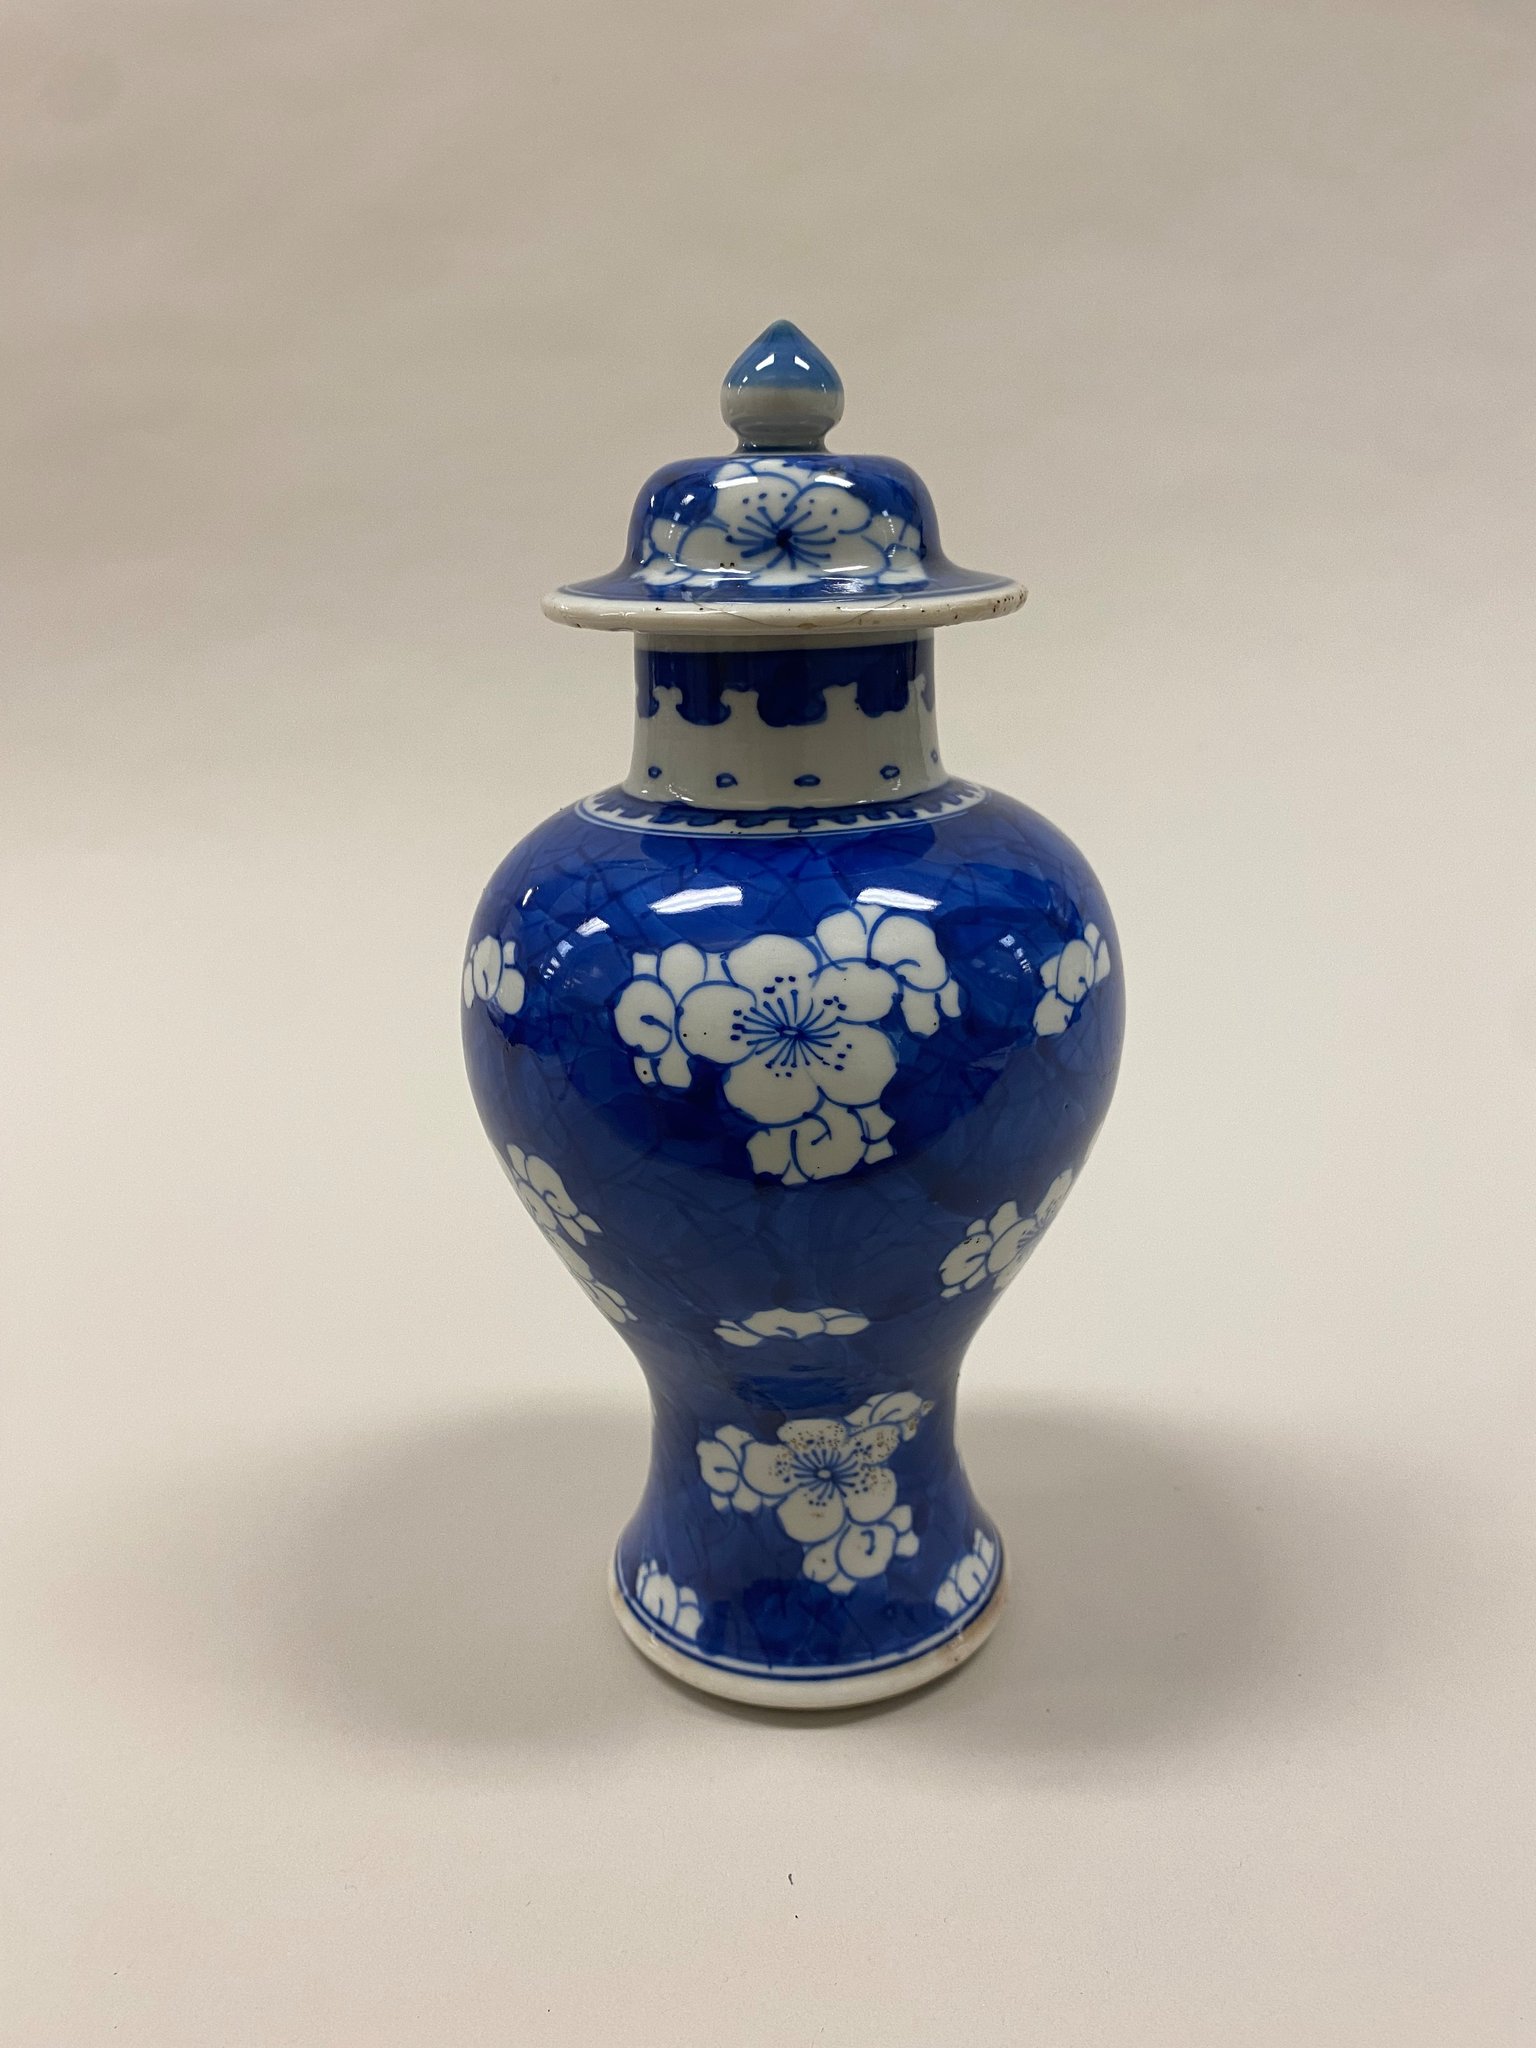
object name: covered jar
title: Covered jar with plum blossoms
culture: chinese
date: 1701-1733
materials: cobalt, porcelain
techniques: painting, underglaze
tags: flowers